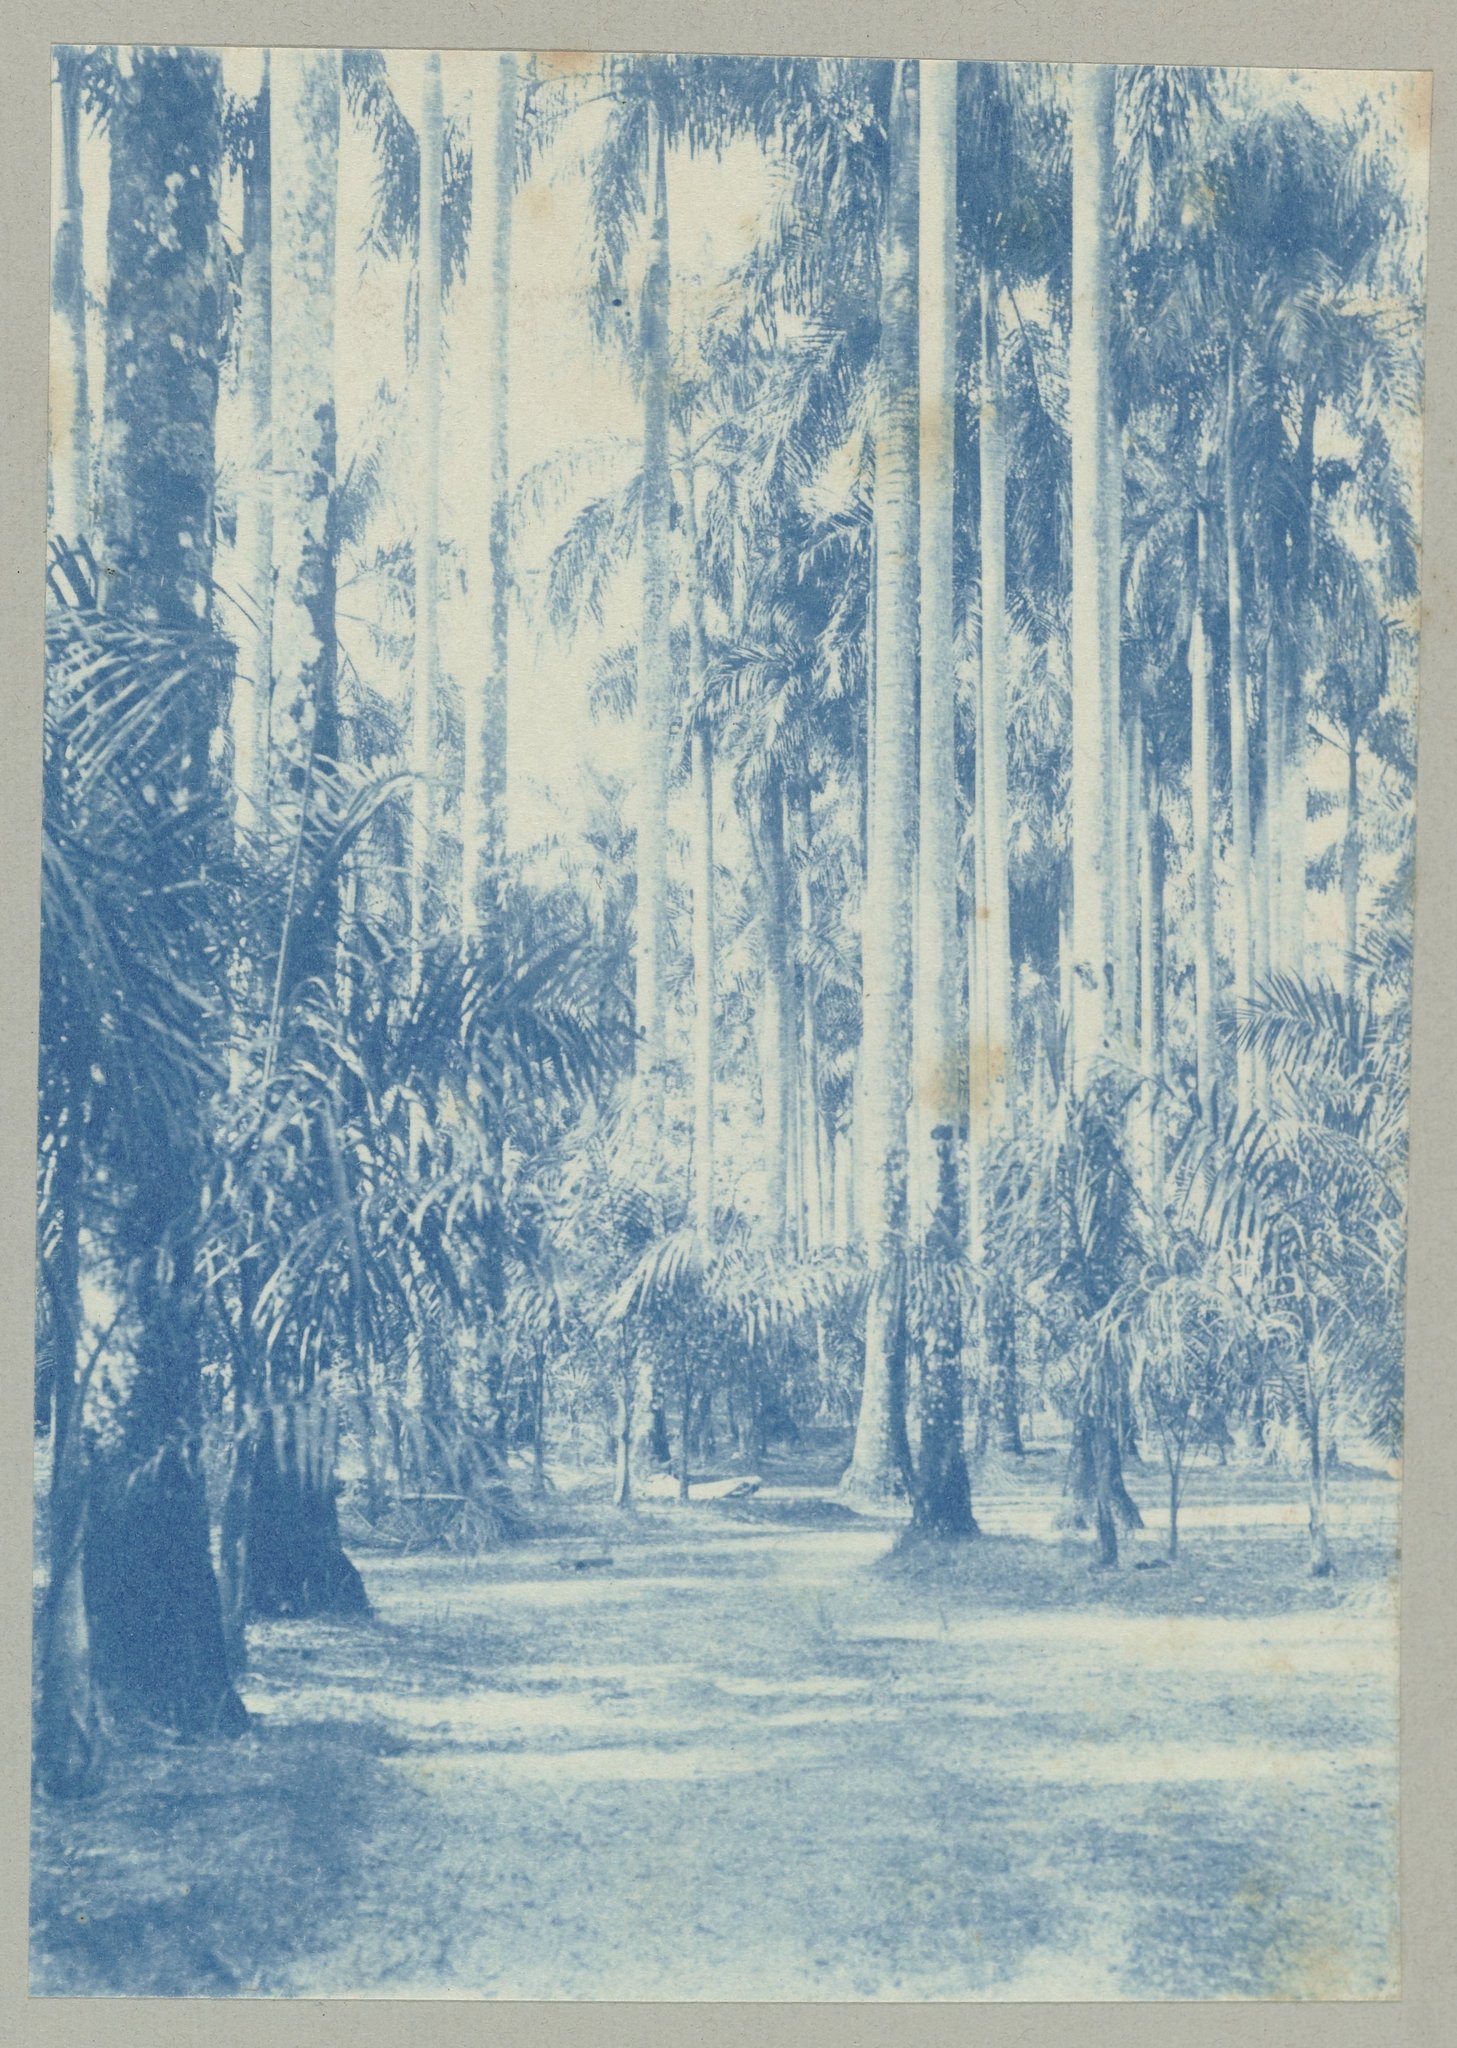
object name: photograph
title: Palmentuin, Paramaribo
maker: hendrik doijer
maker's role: engineer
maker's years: 1863-1925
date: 1903-1910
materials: photographic support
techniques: cyanotype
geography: suriname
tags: suriname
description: Hoge bomen in de Palmentuin te Paramaribo. Onderdeel van het fotoalbum Souvenir de Voyage (deel 2), over het leven van de familie Doijer in en rond de plantage Ma Retraite in Suriname in de jaren 1903-1910.